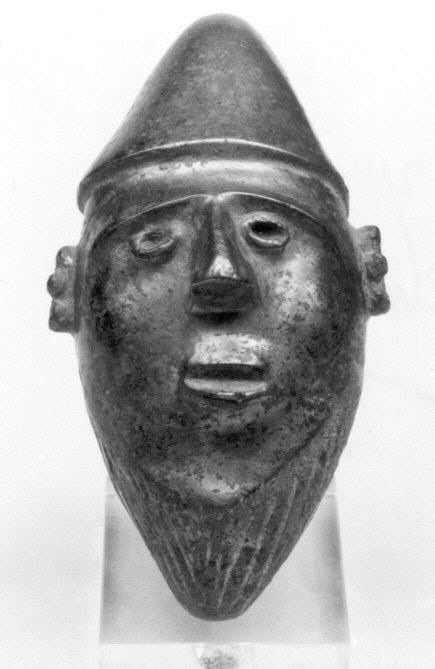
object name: sculpture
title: Head of man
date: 1000-1 BCE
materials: bronze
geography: transcaucasia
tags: heads,men